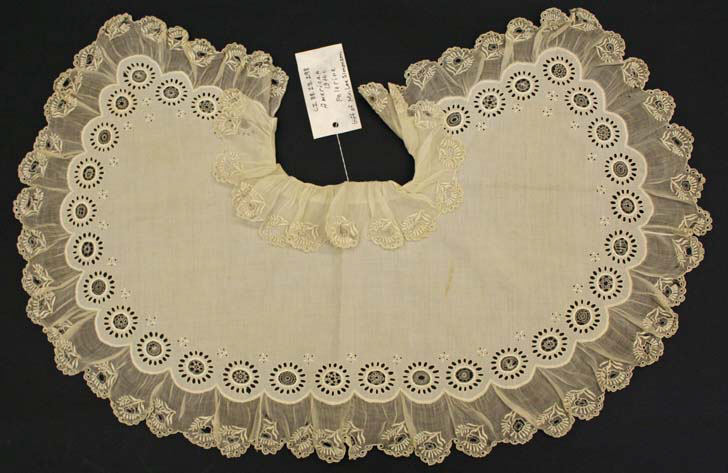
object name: fichu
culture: european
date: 1700-1938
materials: cotton